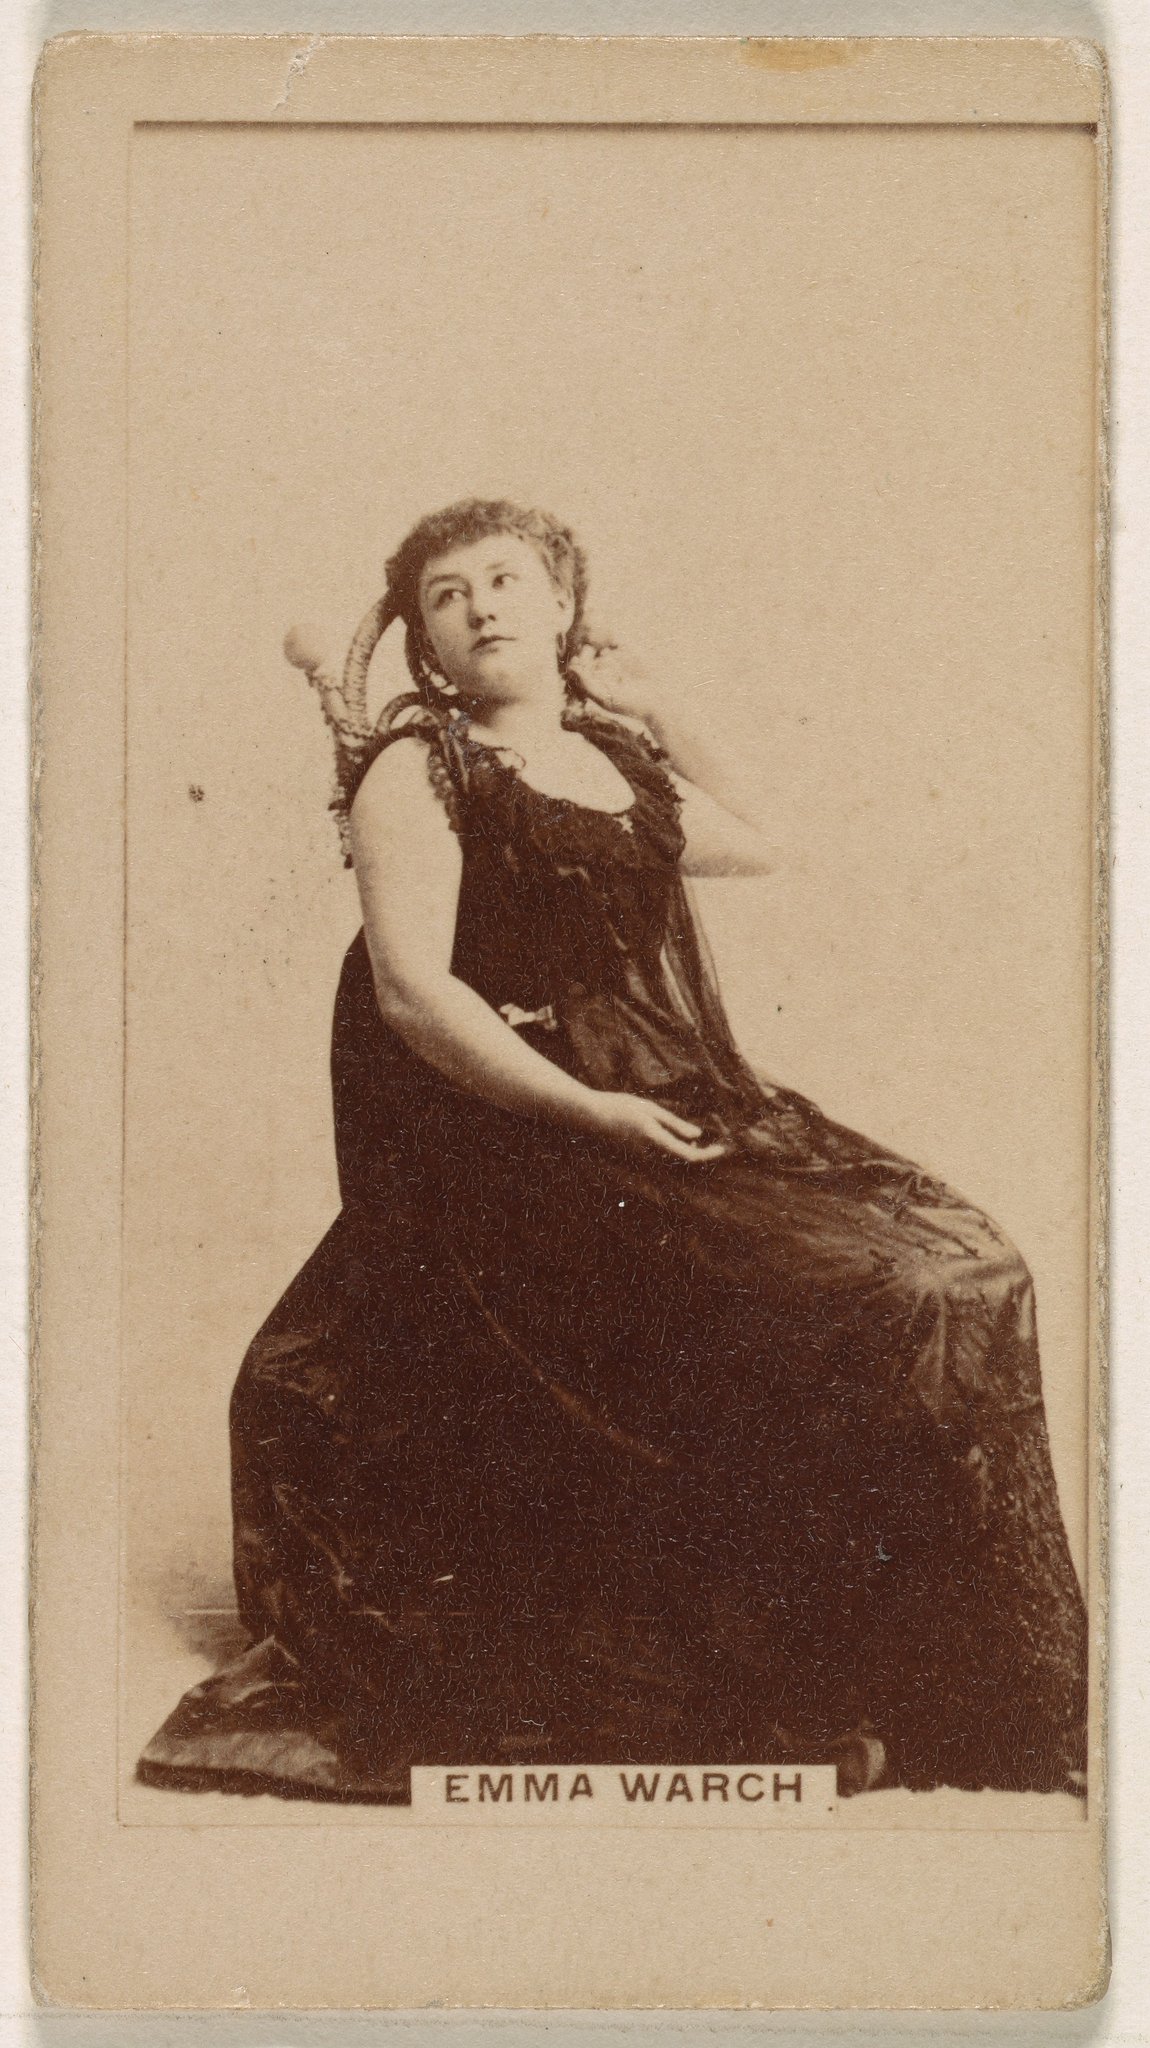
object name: photograph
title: Emma Warch, from the Actresses series (N245) issued by Kinney Brothers to promote Sweet Caporal Cigarettes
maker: kinney brothers tobacco company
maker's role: publisher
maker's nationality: american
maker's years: 1869-2011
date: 1890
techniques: albumen silver print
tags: portraits,women,actresses